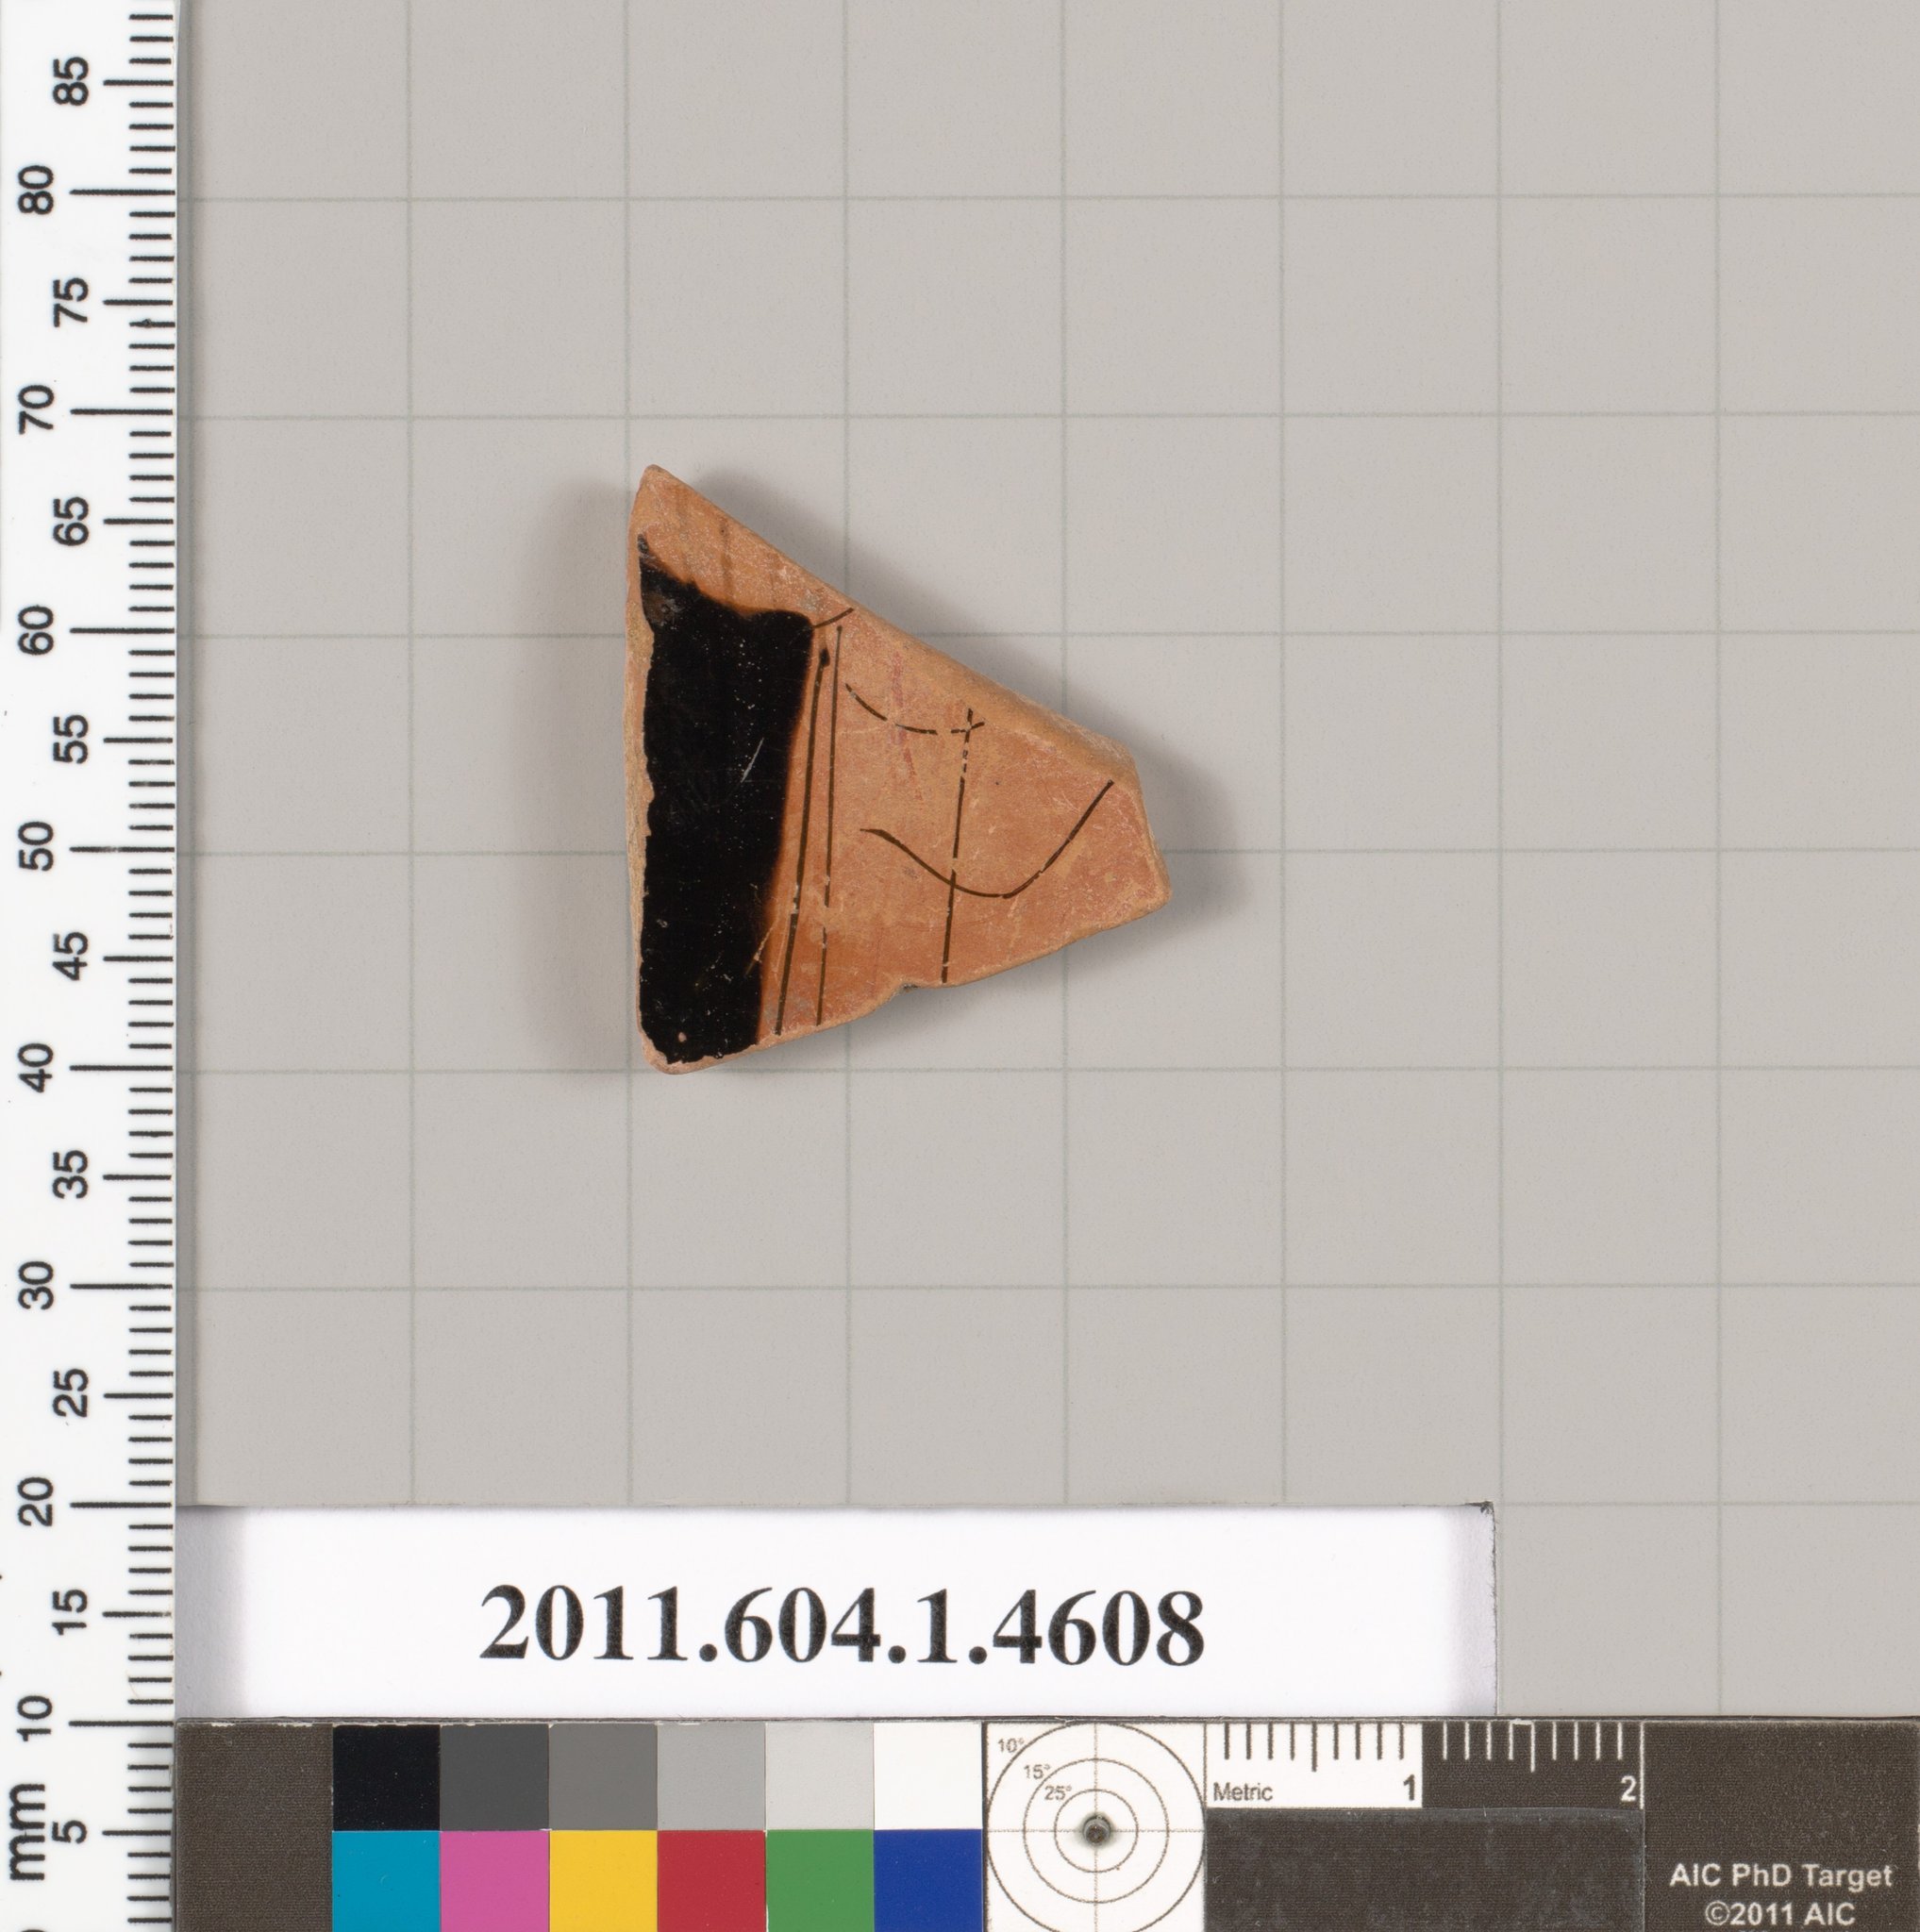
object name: kylix fragment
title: Terracotta fragment of a kylix (drinking cup)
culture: greek, attic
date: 467-435 BCE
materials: terracotta